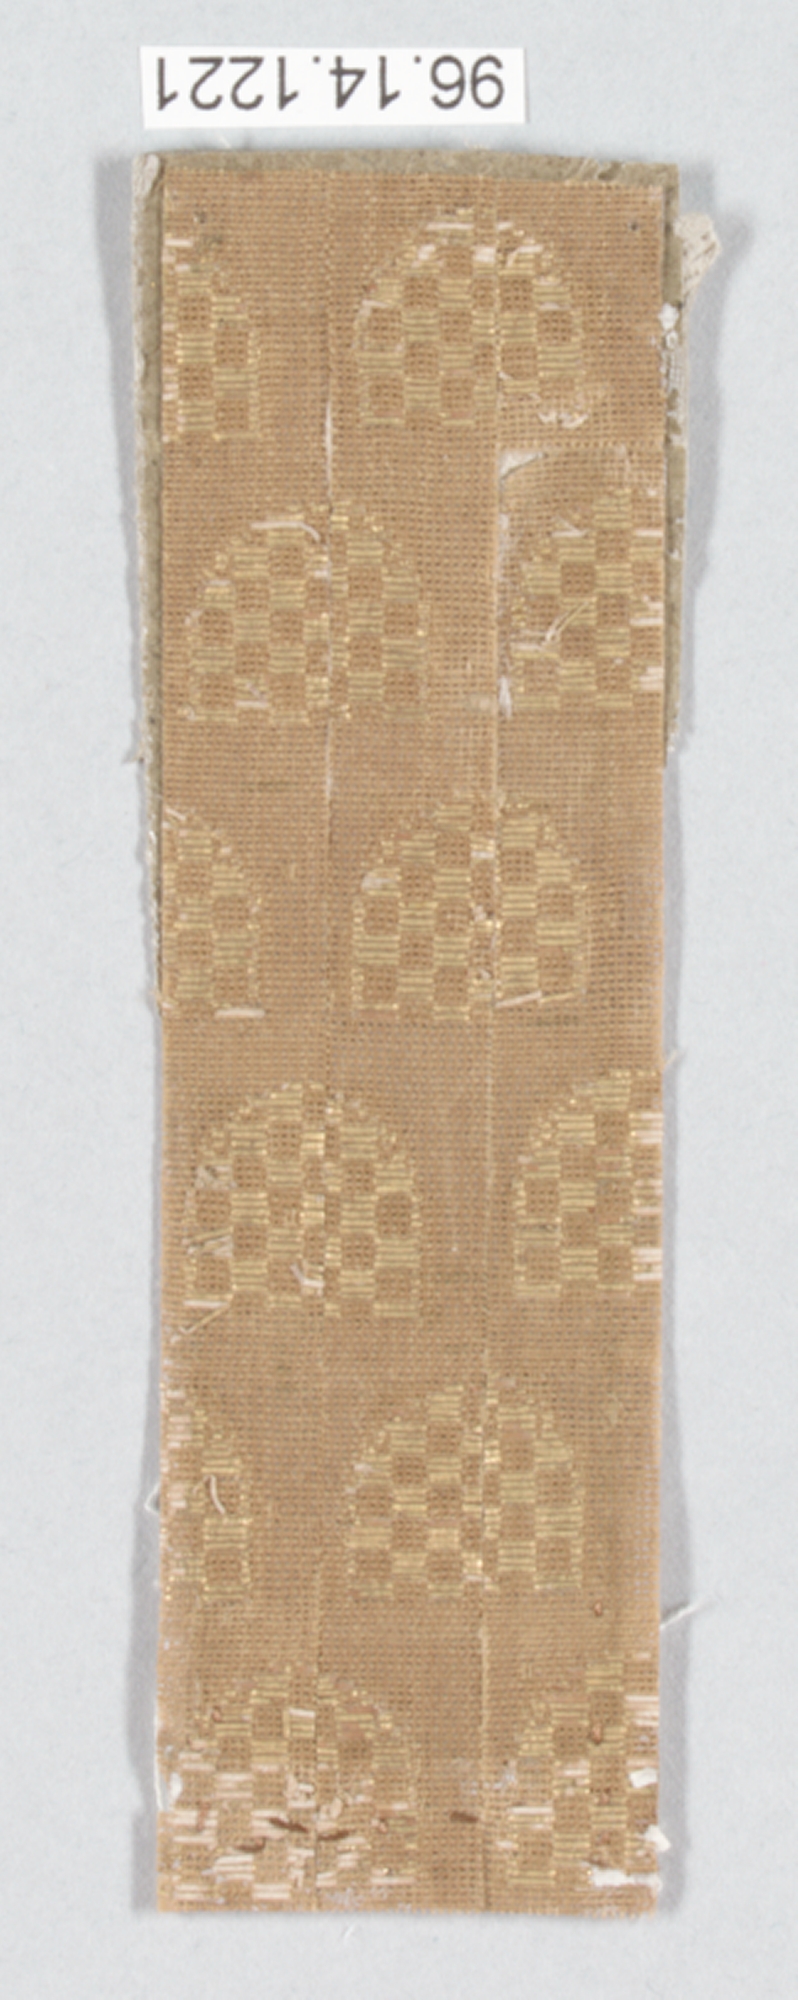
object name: piece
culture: japanese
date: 1101-1400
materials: silk